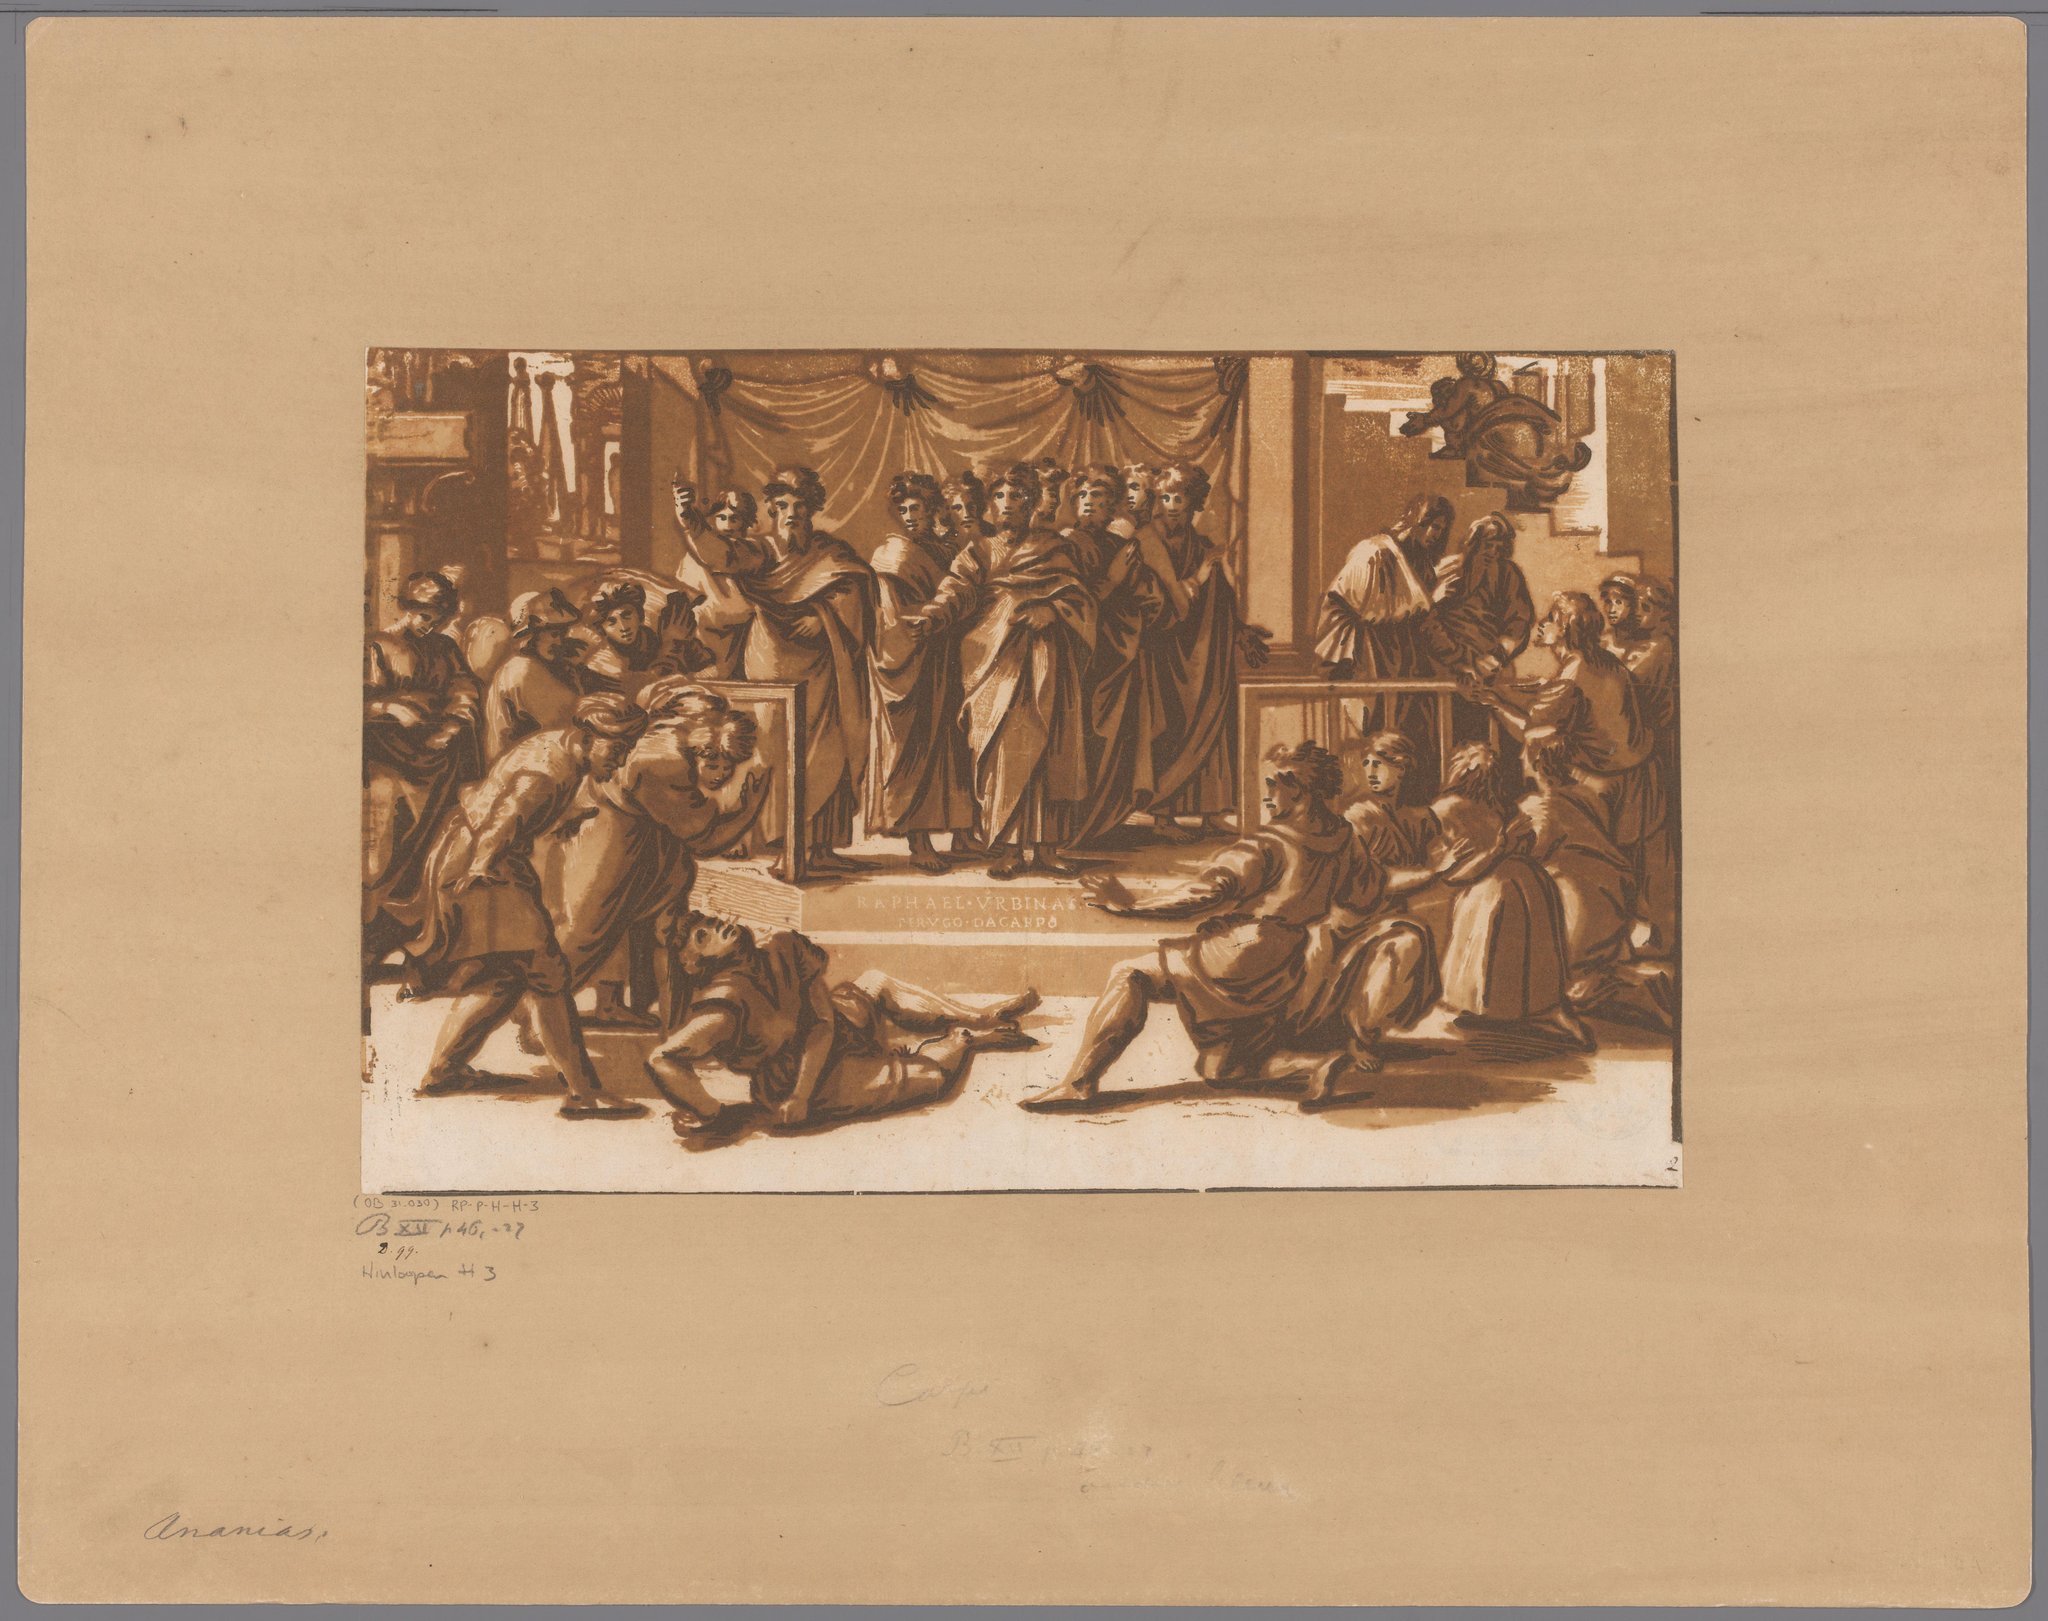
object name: print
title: Dood van Ananias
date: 1518-1532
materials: paper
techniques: woodcut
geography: italy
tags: ananias, rebuked by peter, falls down and dies between his gifts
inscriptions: collector's mark: Lugt 10, collector's mark: Lugt 11, number: ‘2’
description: Vooraan ligt Ananias op de grond. Omstanders kijken verbijsterd toe. In het midden staat Petrus op een podium samen met acht mannen. Hij gebaart met zijn rechterhand. Rechts delen twee apostelen geld uit.